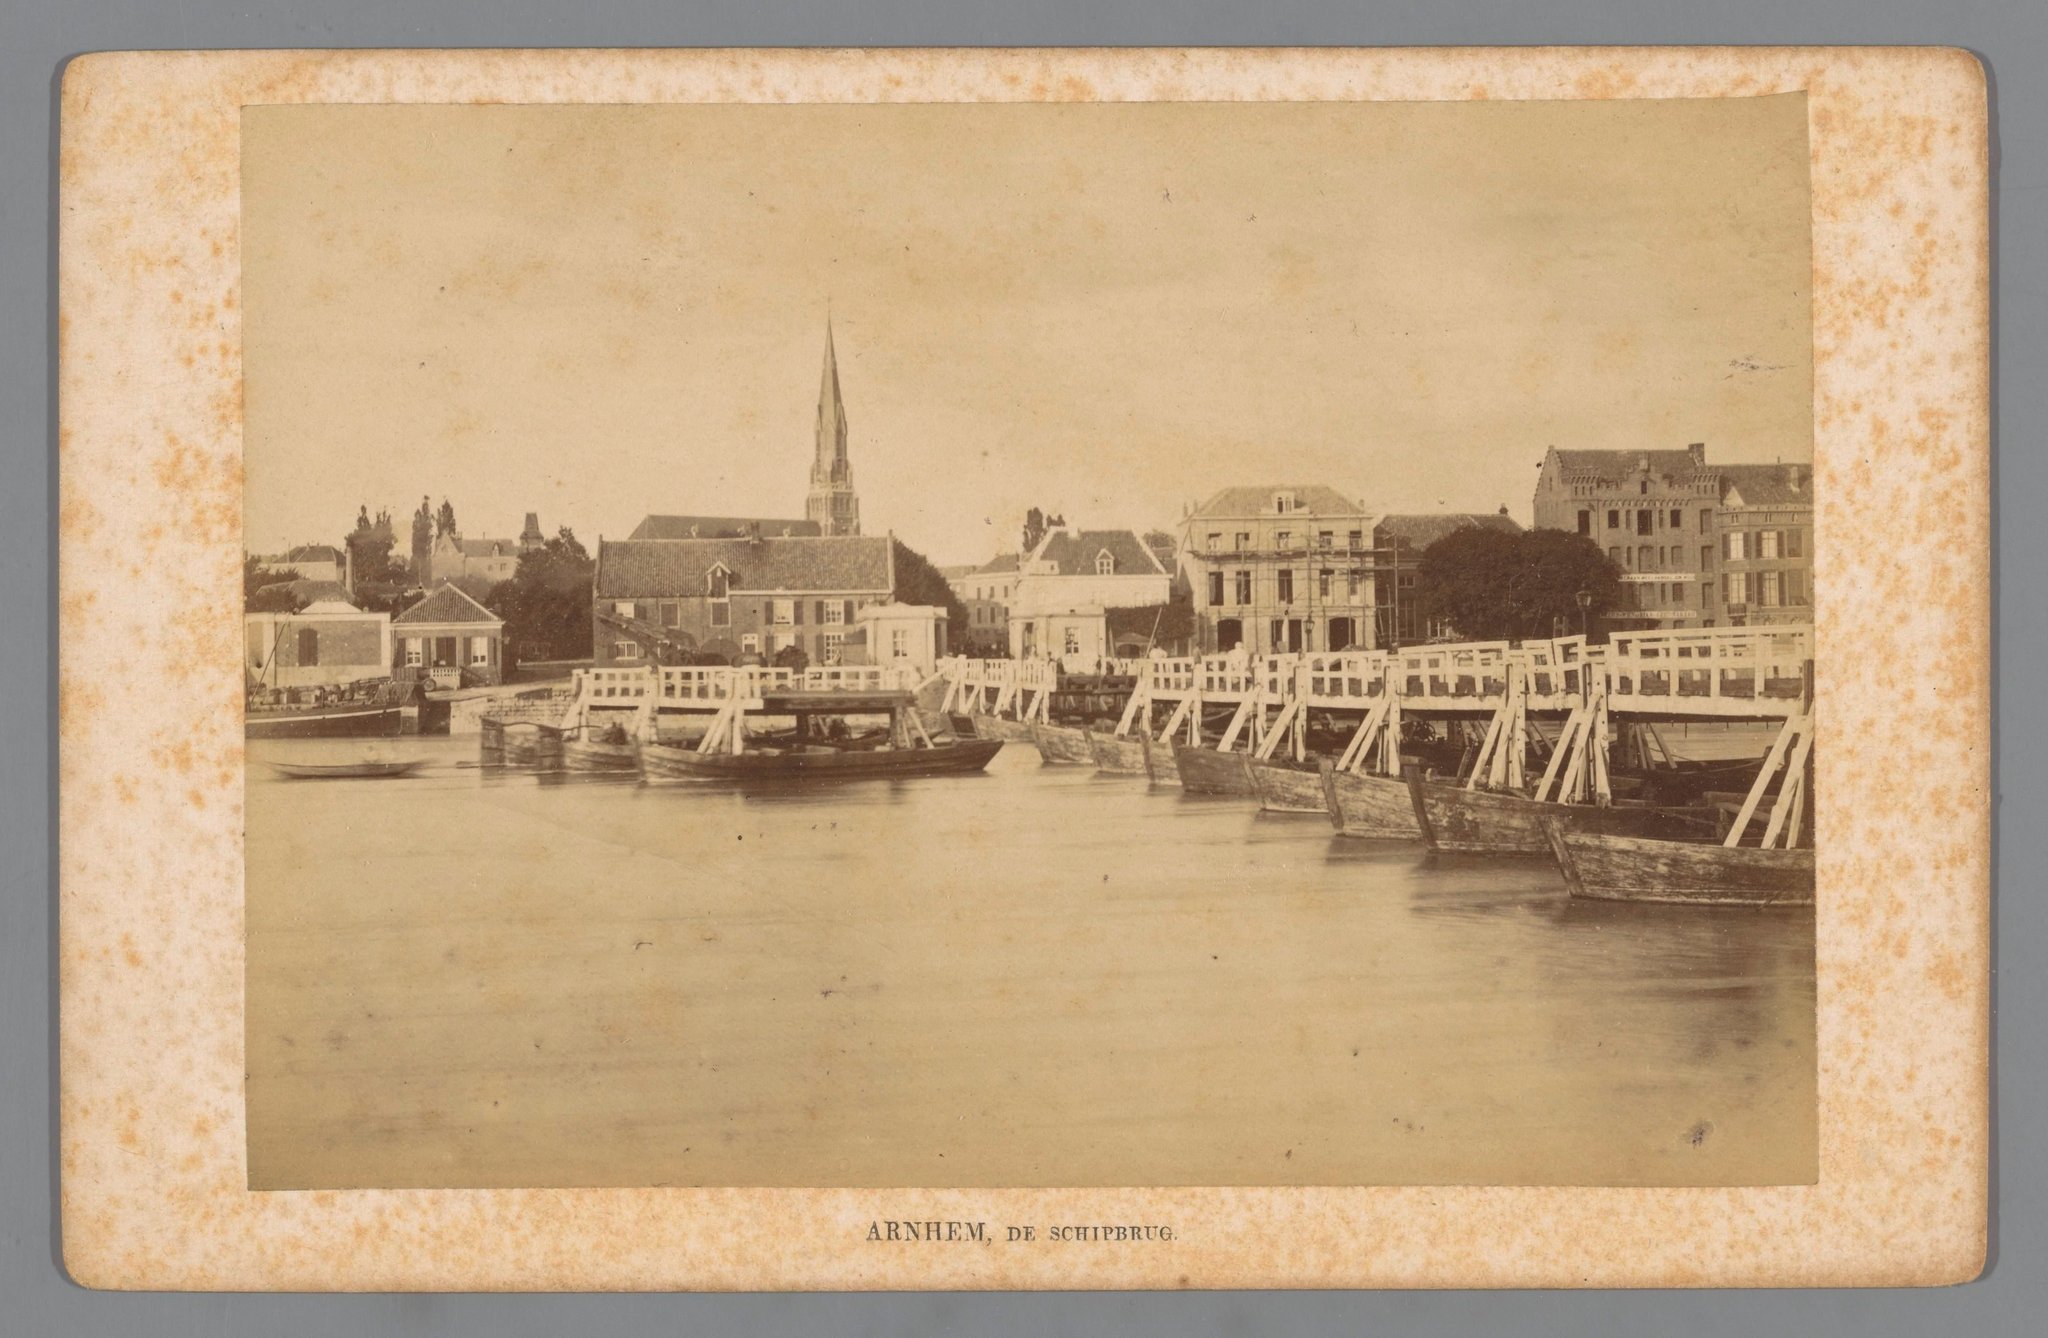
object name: photograph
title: Arnhem, de Schipbrug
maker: Anonymous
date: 1850-1900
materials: cardboard, photographic support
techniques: albumen print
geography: arnhem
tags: canals, waters (in city), arnhem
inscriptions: number: ‘1’, date: ‘Mei '94’